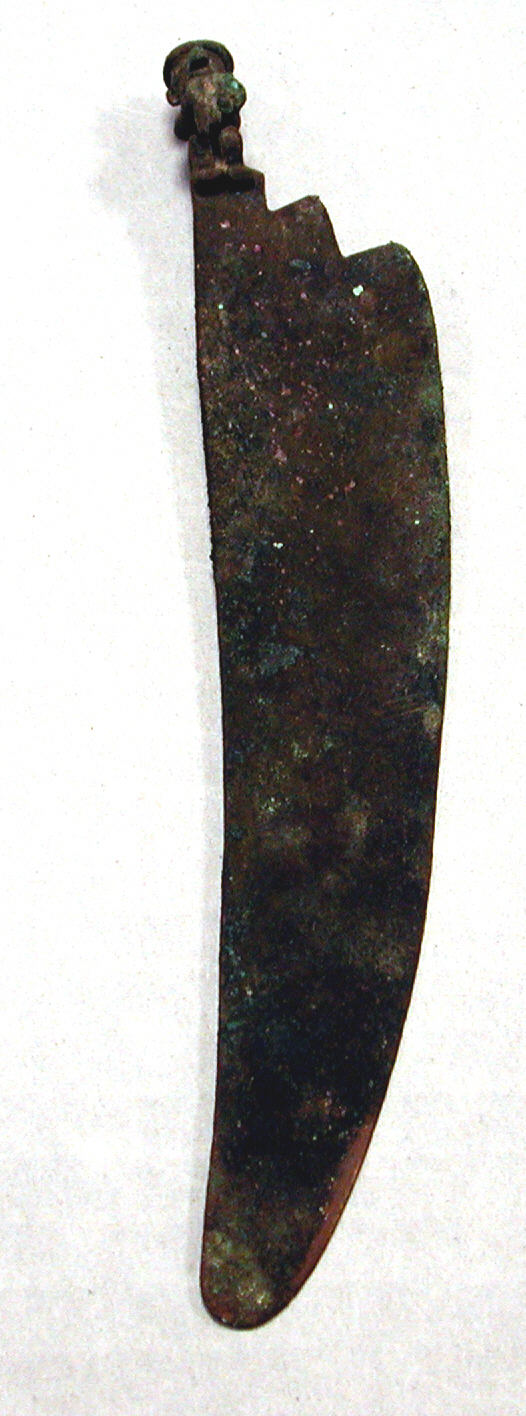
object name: knife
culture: inca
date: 1401-1600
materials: copper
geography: peru